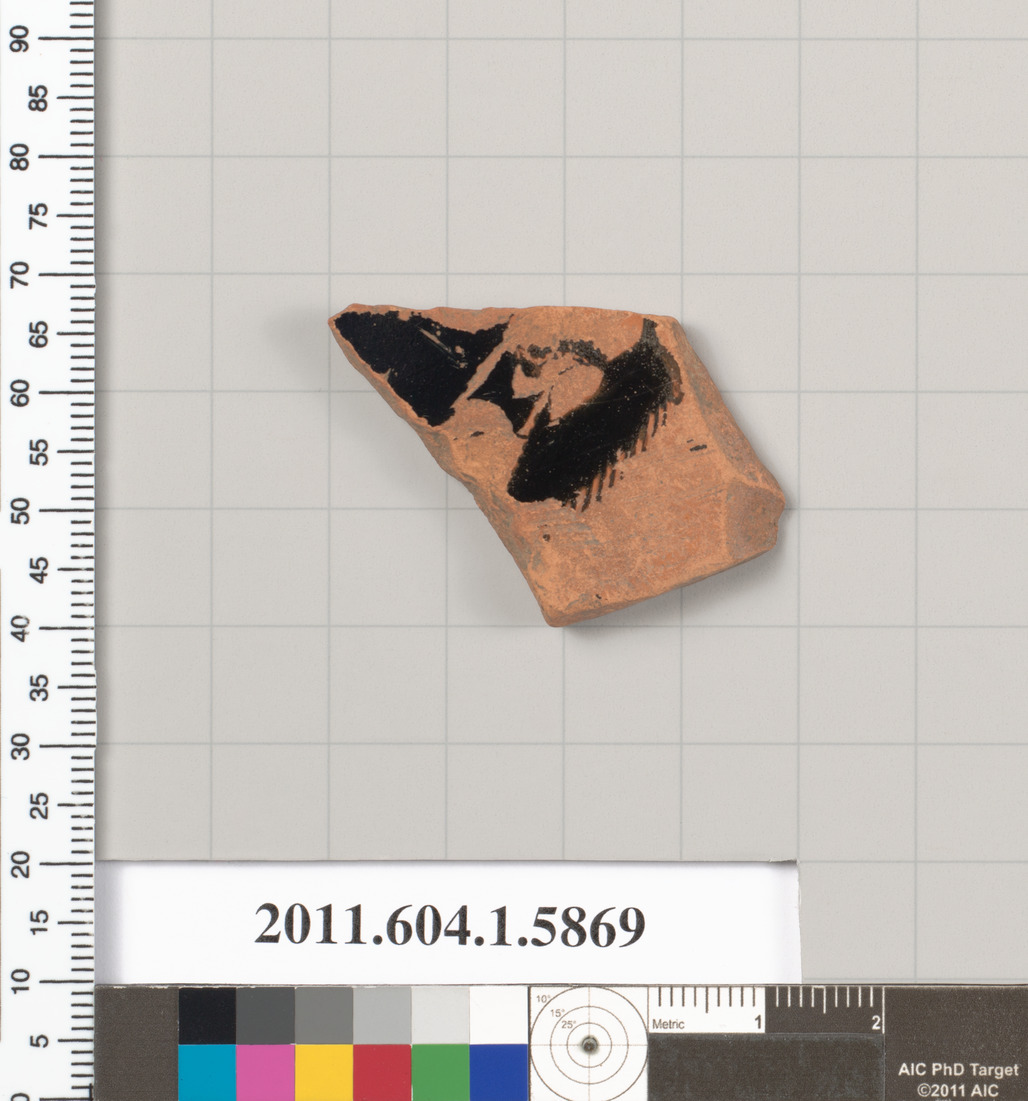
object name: kylix fragment, eye cup, bilingual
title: Terracotta fragment of a kylix (drinking cup)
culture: greek, attic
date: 433-567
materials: terracotta